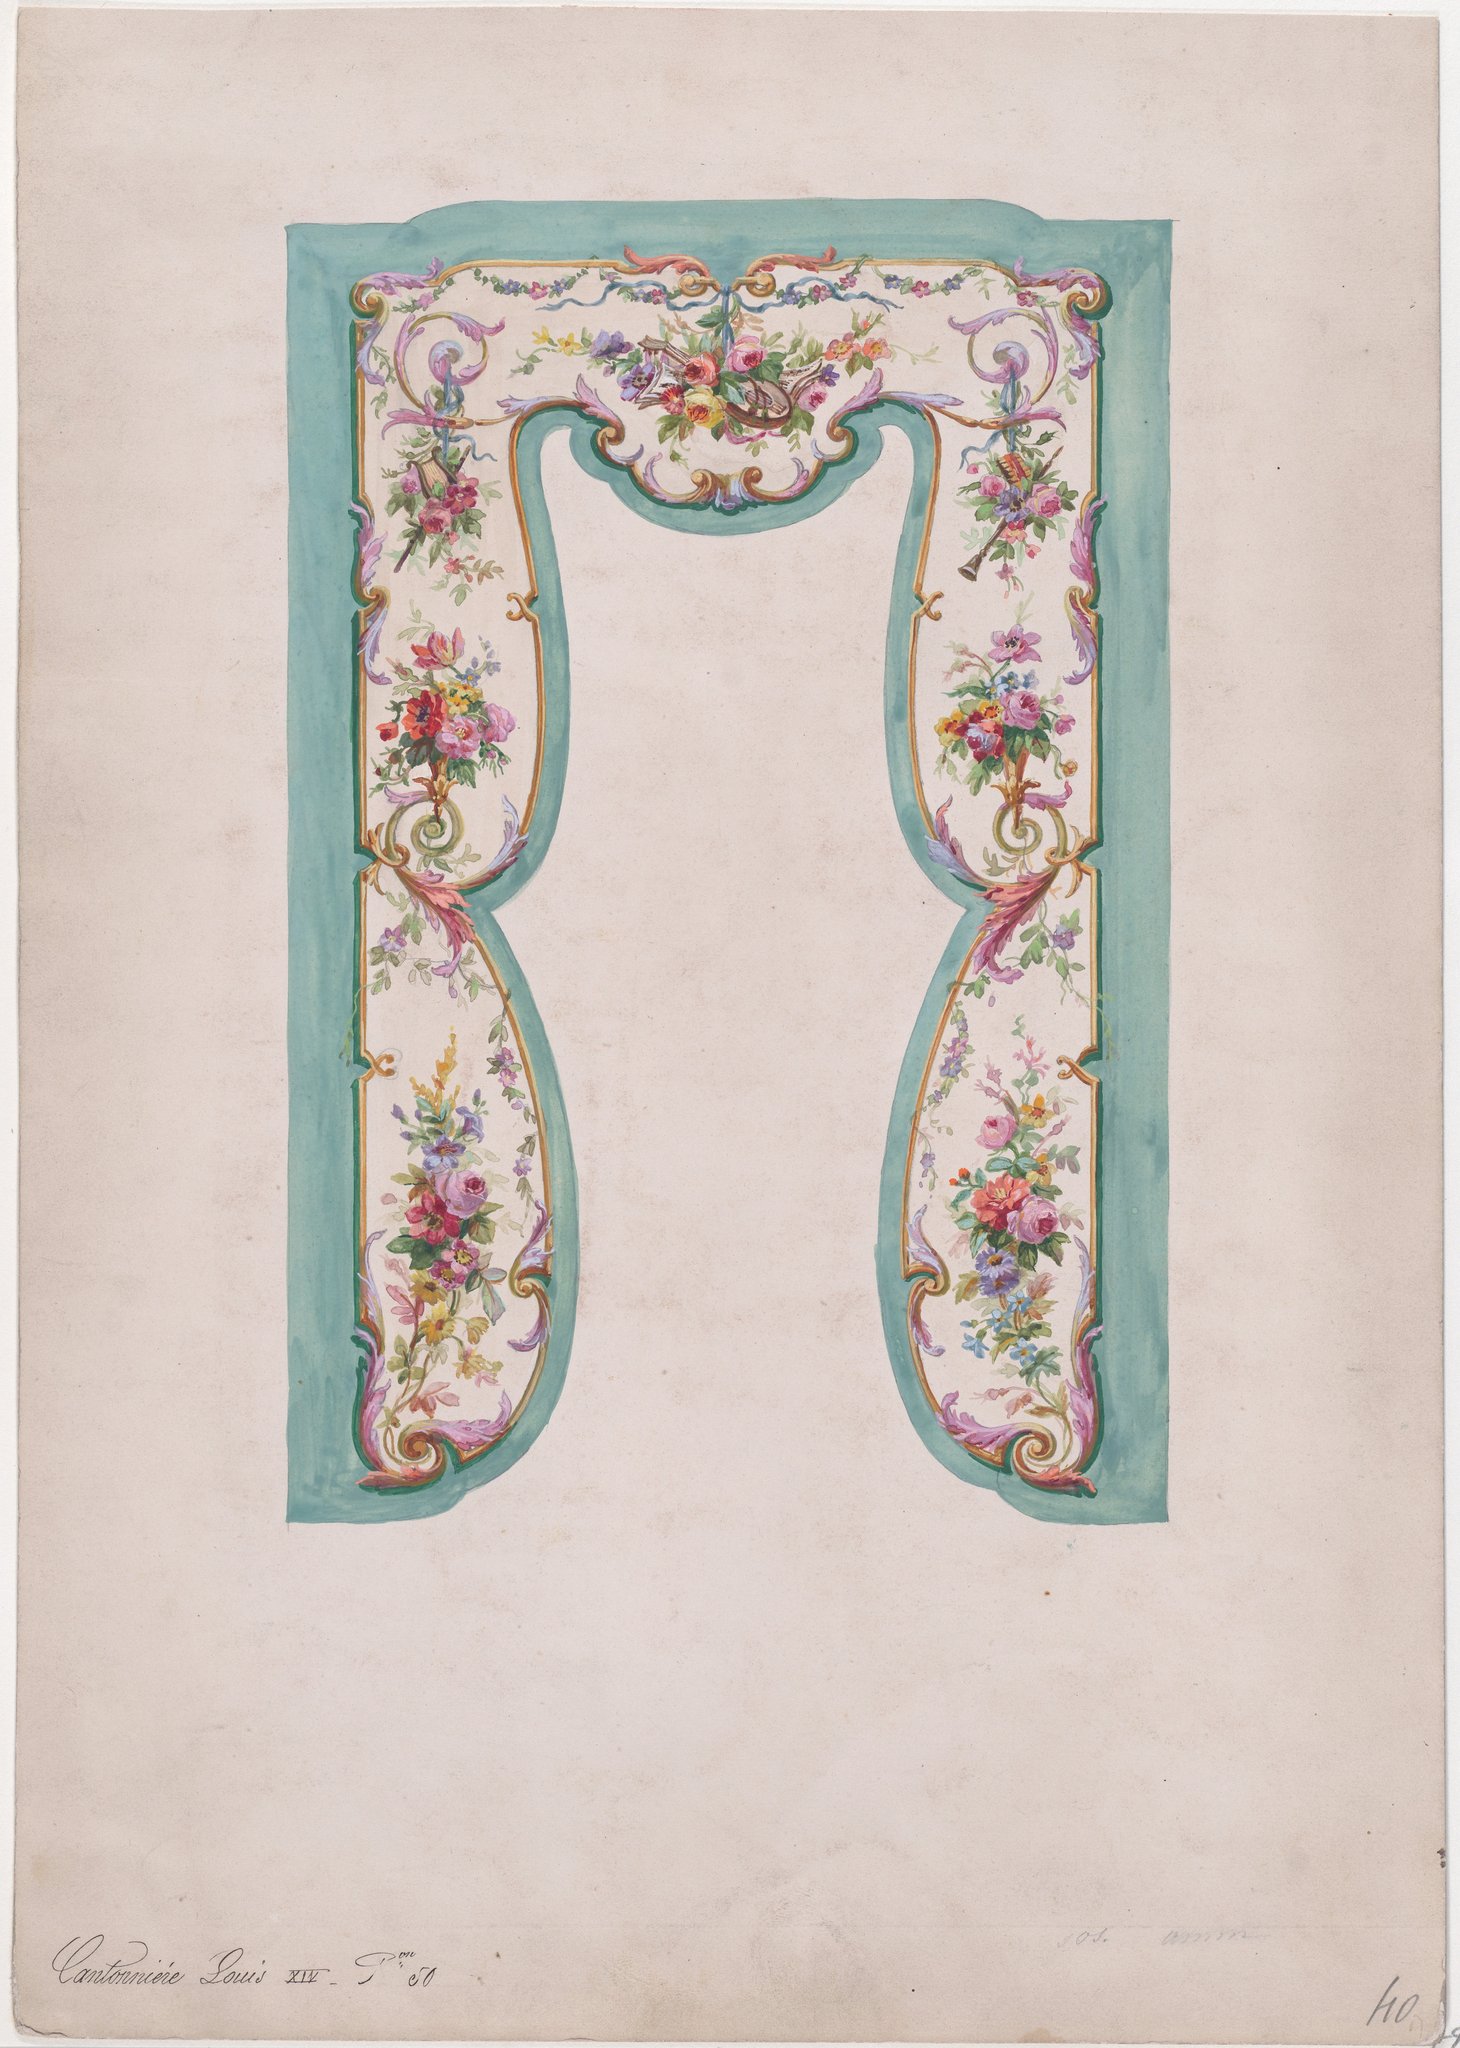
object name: drawing ornament architecture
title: Design for a Valance with Bundles and Garlands of Flowers and Musical Instruments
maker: anonymous, french, 19th century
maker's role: designer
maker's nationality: french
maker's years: 1800-1900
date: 1870-1900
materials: watercolor